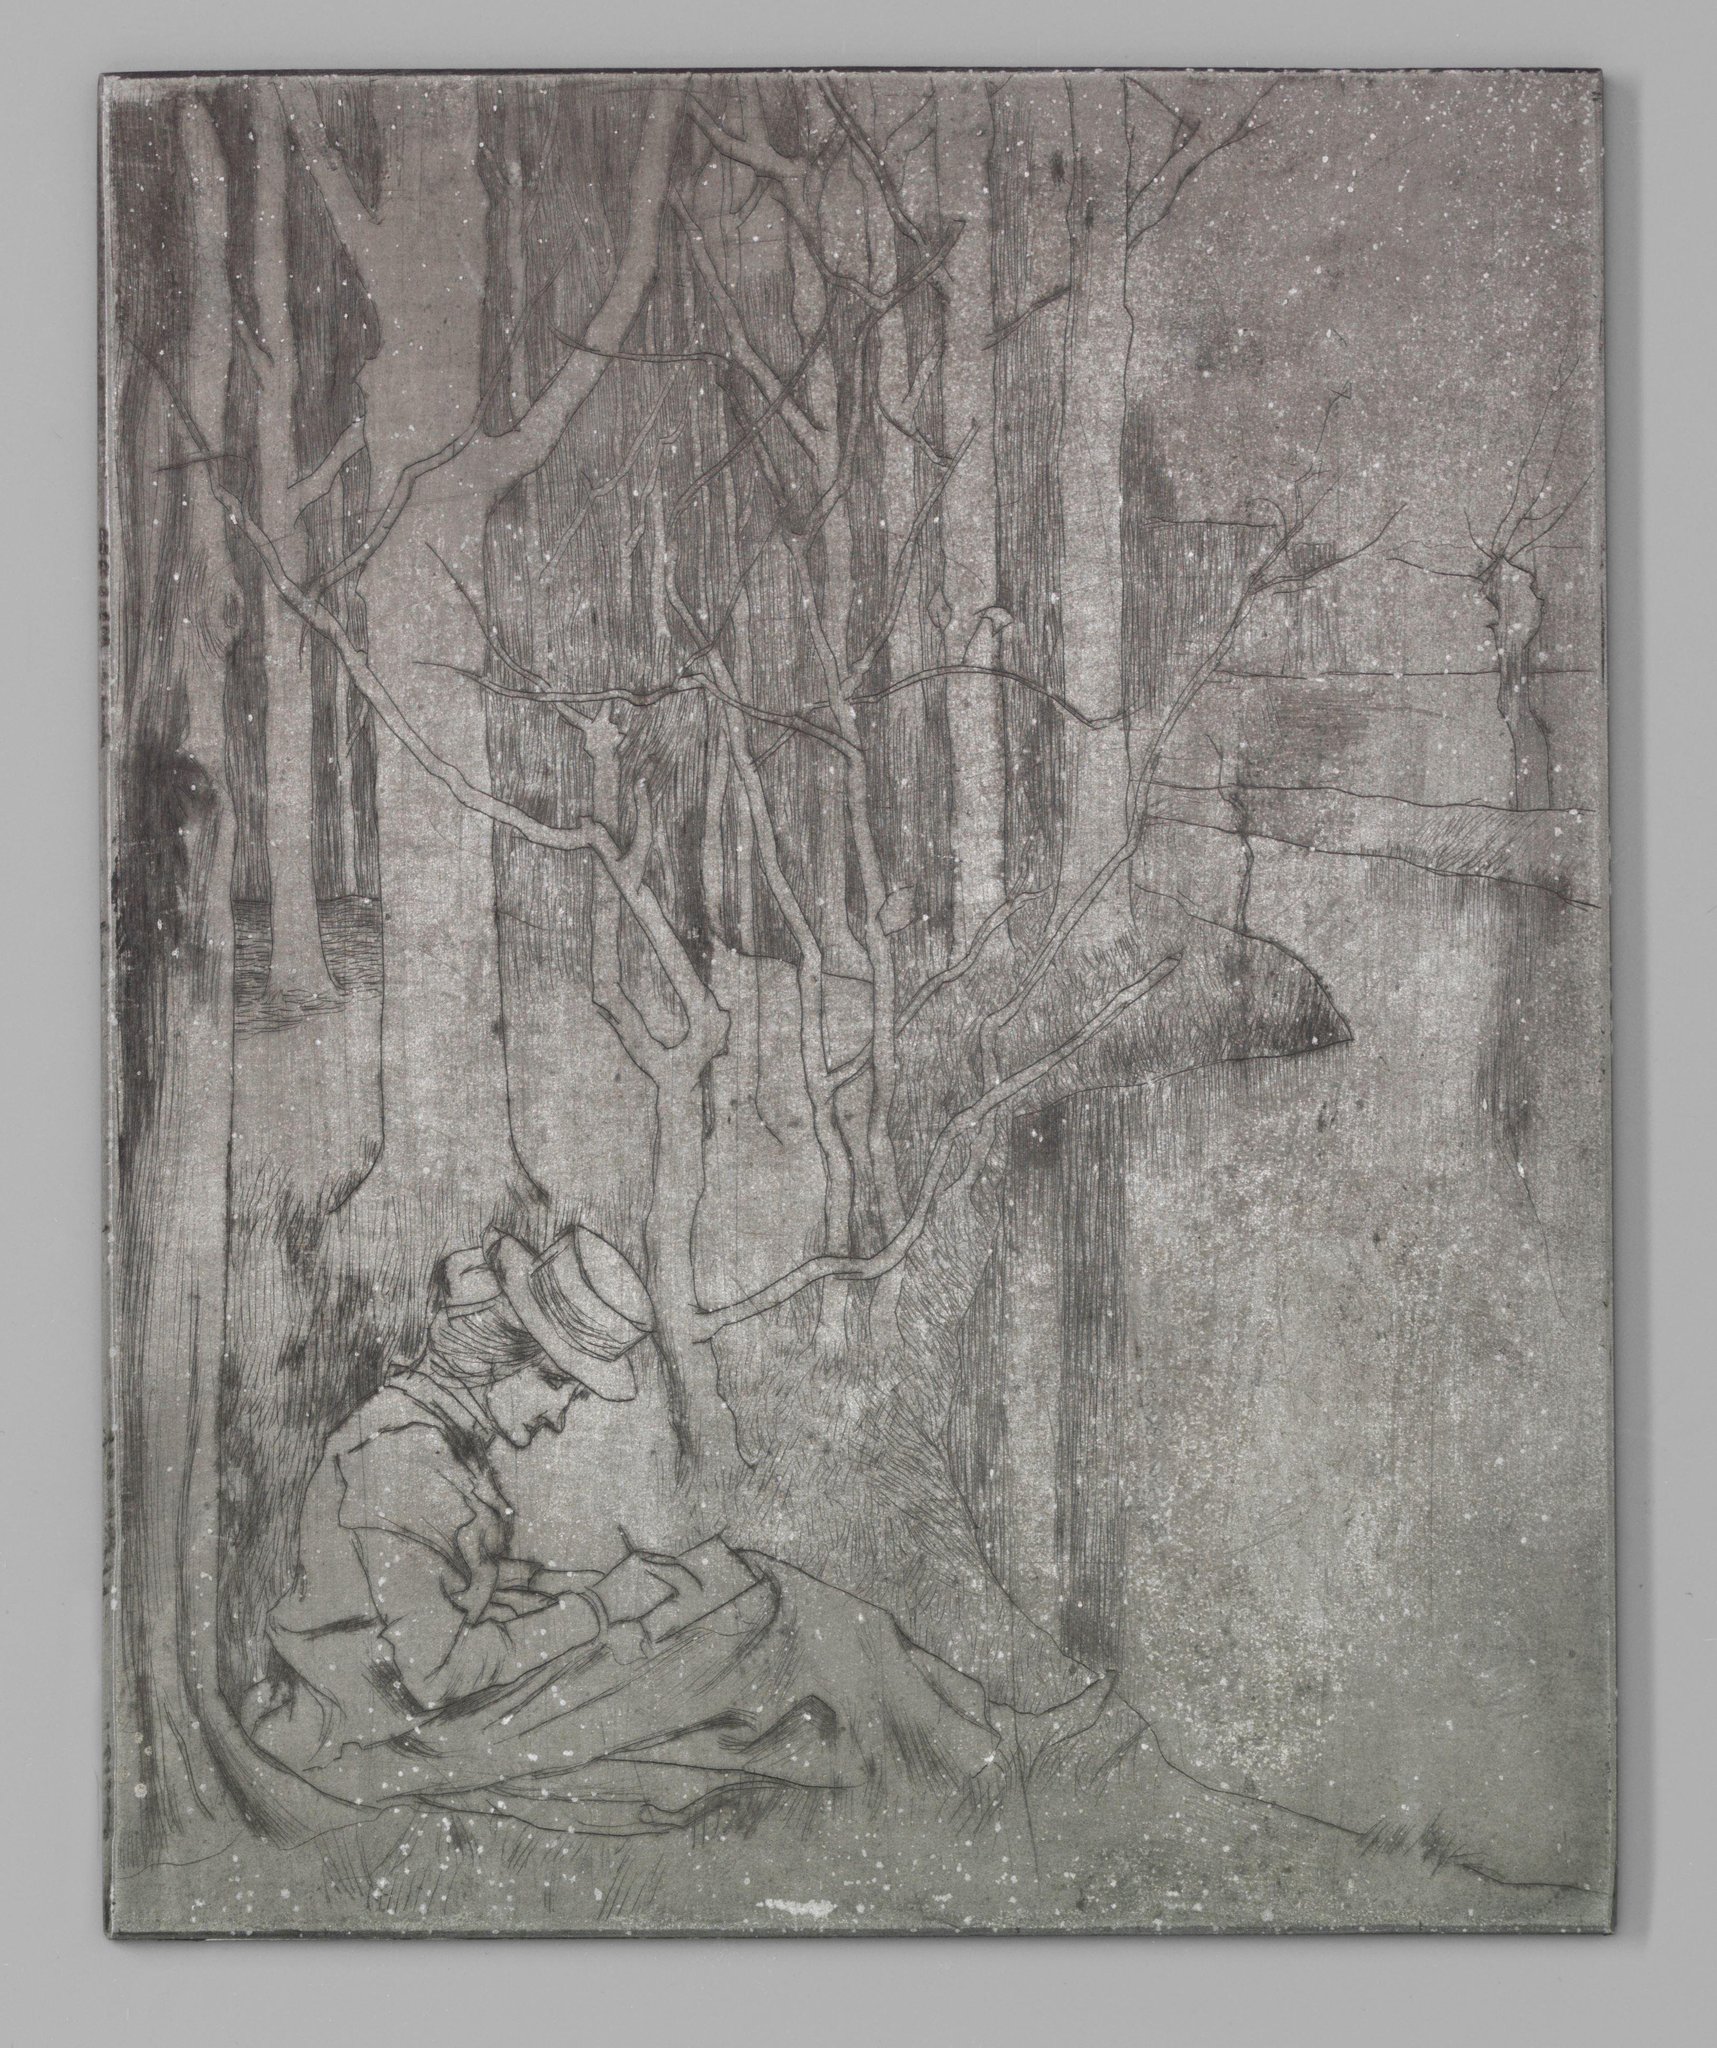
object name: zinkplaat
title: Schrijvende vrouw aan het water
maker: jan toorop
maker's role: draughtsman, painter, print maker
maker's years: 1858-1928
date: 1898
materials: zinc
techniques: drypoint